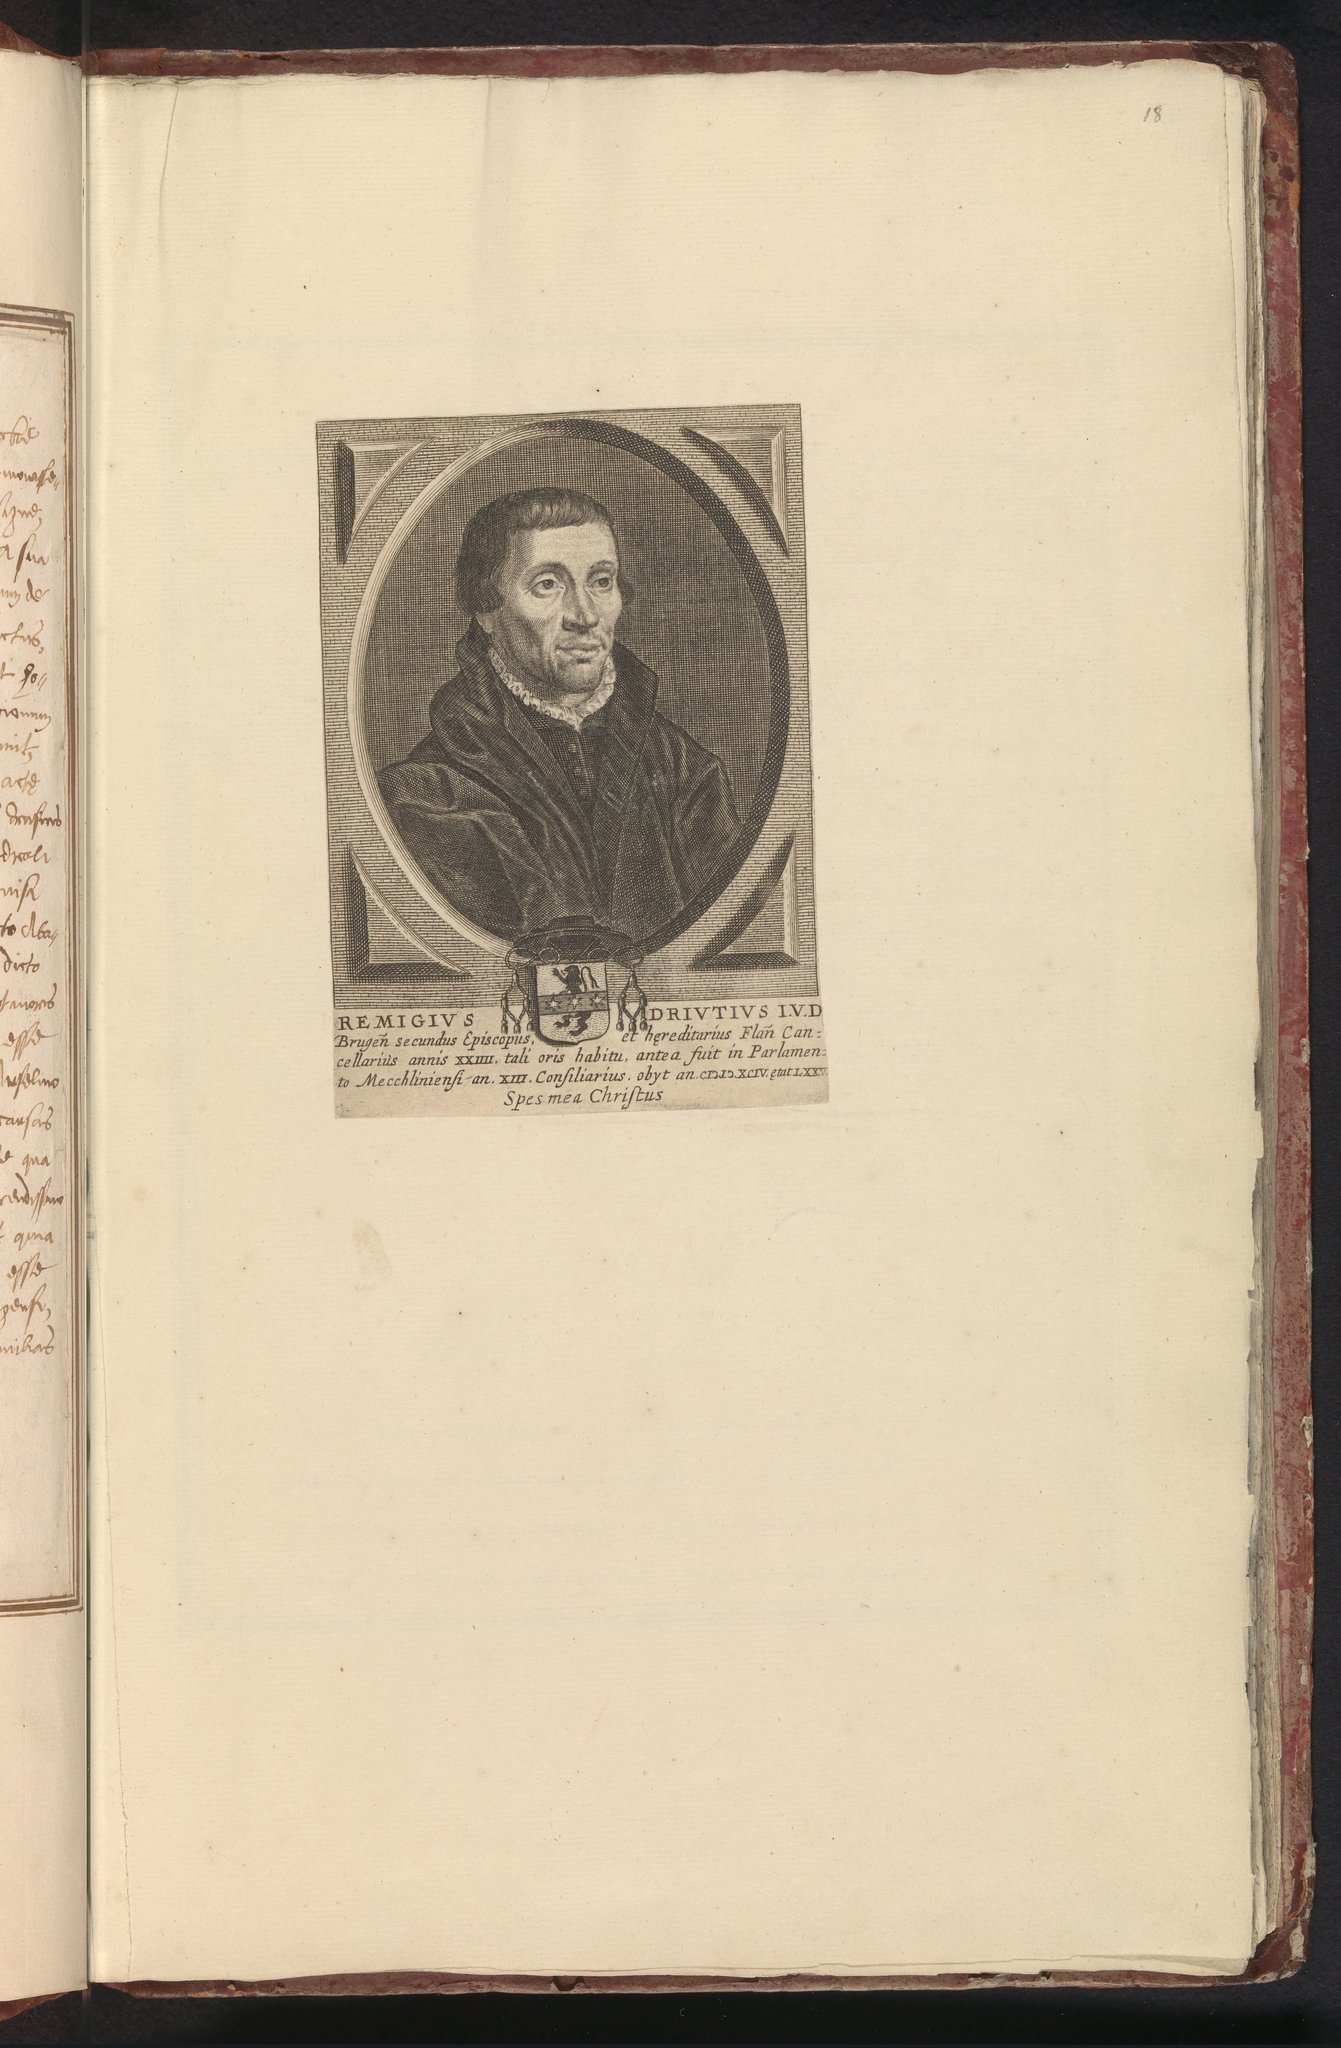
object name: print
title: Portret van Remigius Driutius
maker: Anonymous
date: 1650-1750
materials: ink, paper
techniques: engraving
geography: southern netherlands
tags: archbishop, bishop, etc. (roman catholic), bruges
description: Portret van Remigius Driutius, bisschop van Brugge. Onderdeel van het eerste album met tekeningen van viervoeters. Eerste van twaalf albums met tekeningen van dieren, vogels en planten bekend rond 1600, gemaakt in opdracht van keizer Rudolf II. Met toelichting in Nederlands, Latijn en Frans.